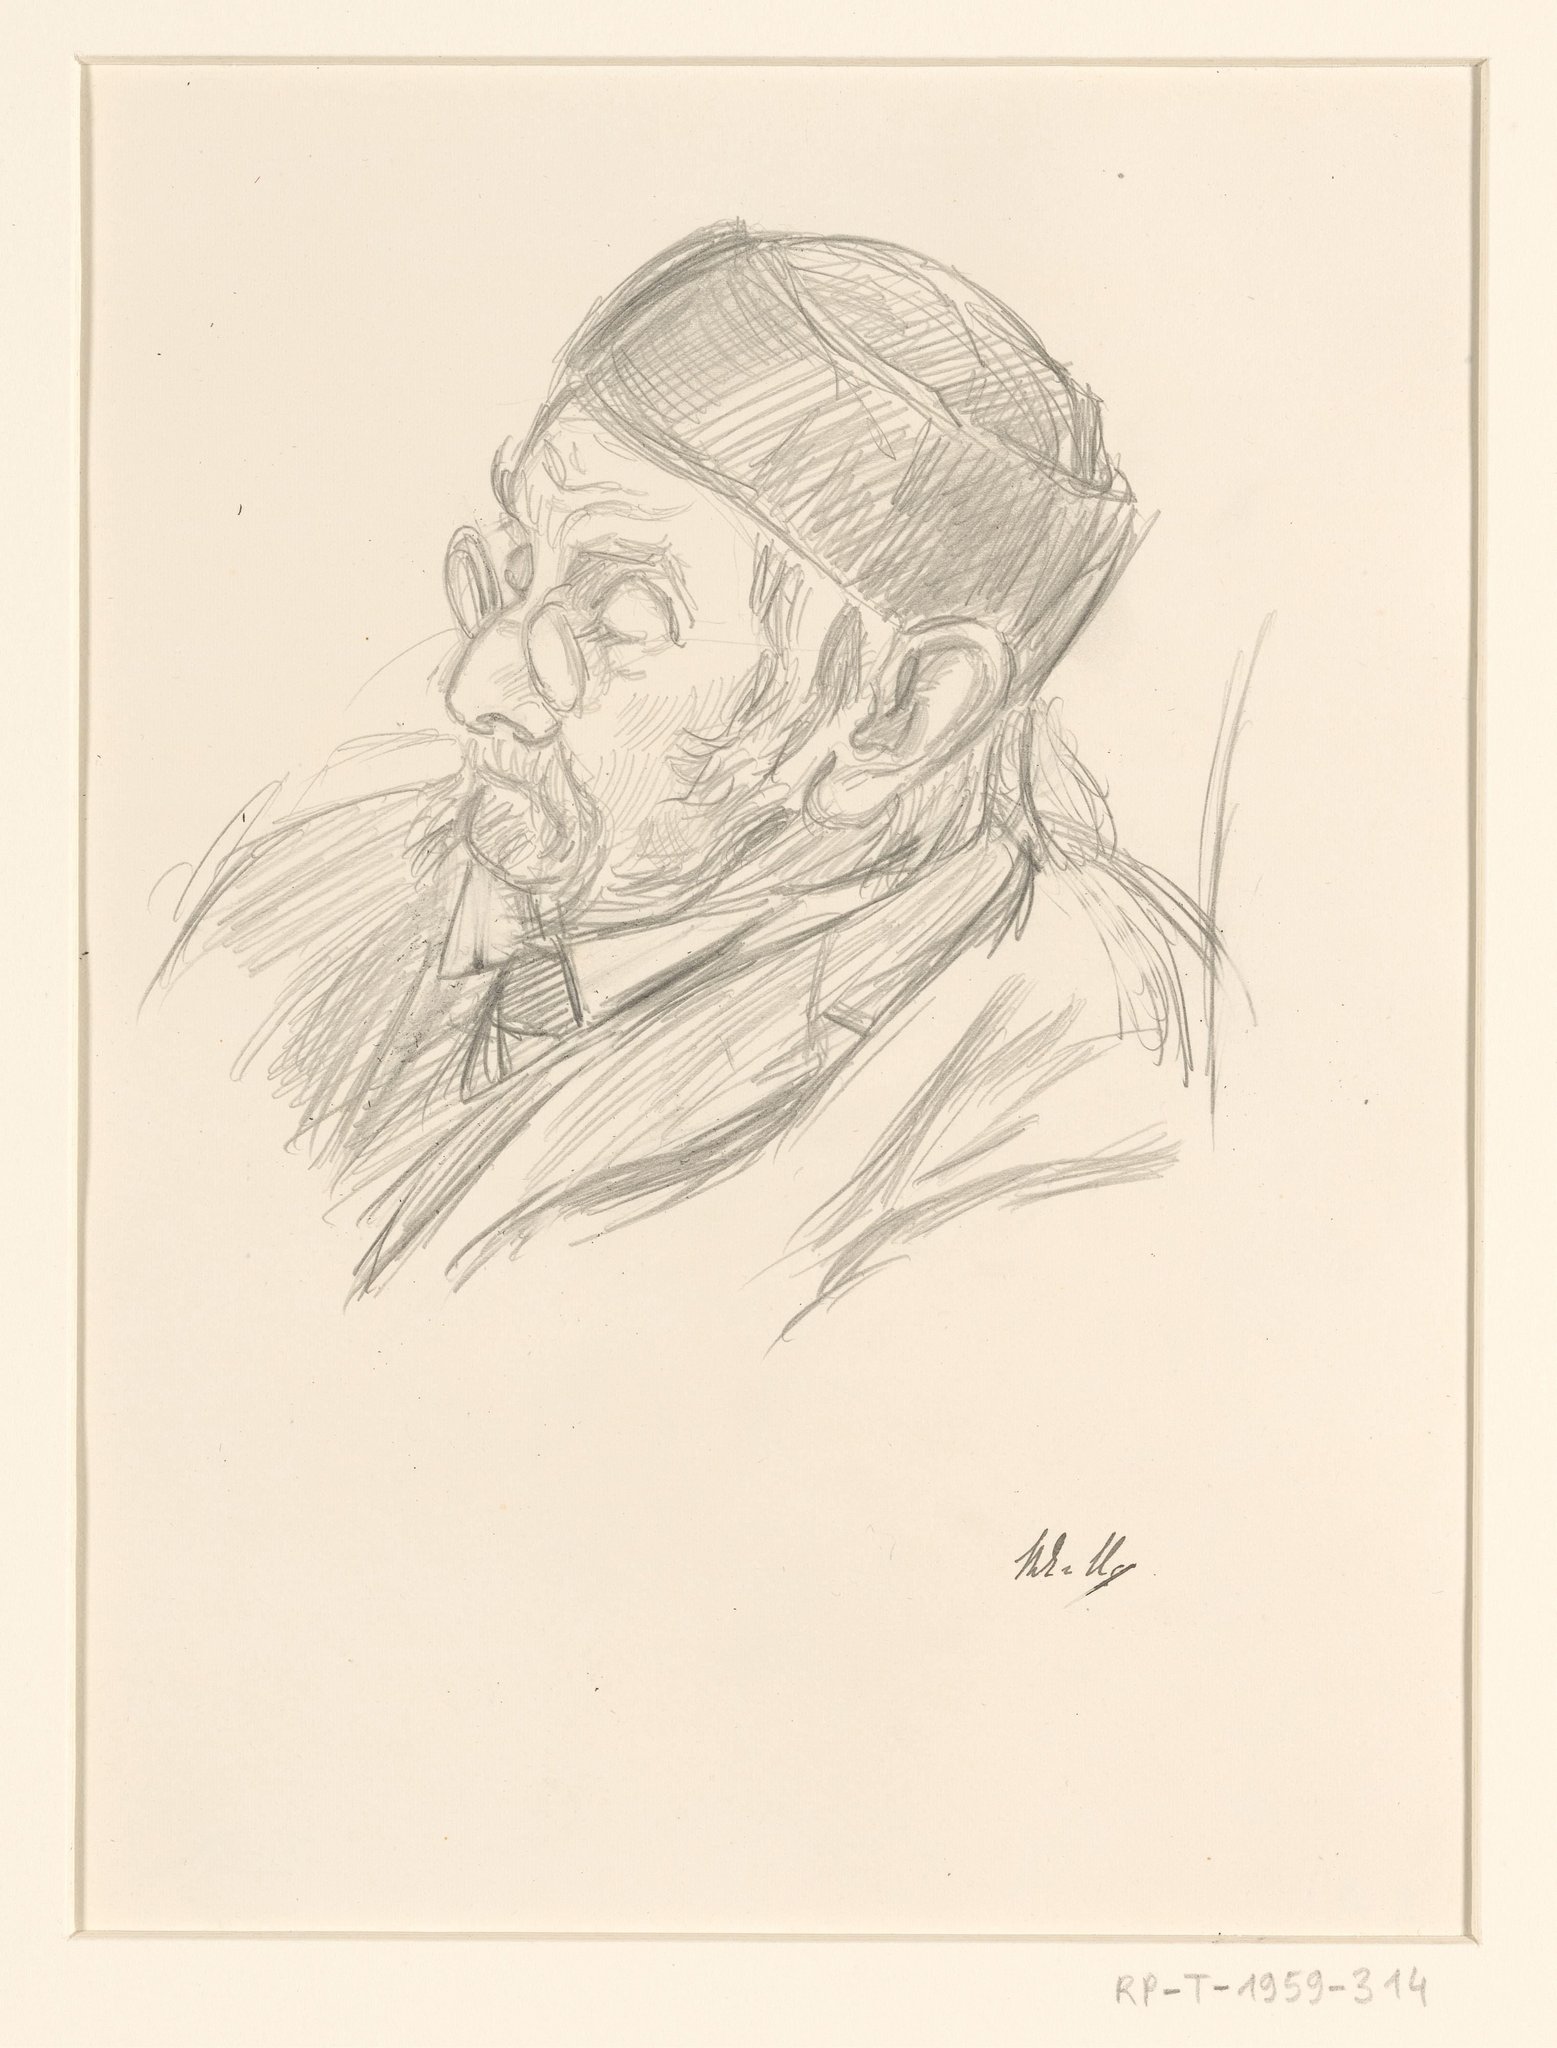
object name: drawing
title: Portret van mr. Samuel van Houten, op hoge leeftijd, driekwart naar links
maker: barbara elisabeth van houten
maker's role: draughtsman, print maker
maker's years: 1862-1950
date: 1872-1950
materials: paper, pencil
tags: politician, samuel van houten, historical persons